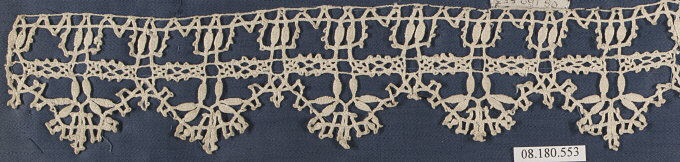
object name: fragment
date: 1601-1700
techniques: lace